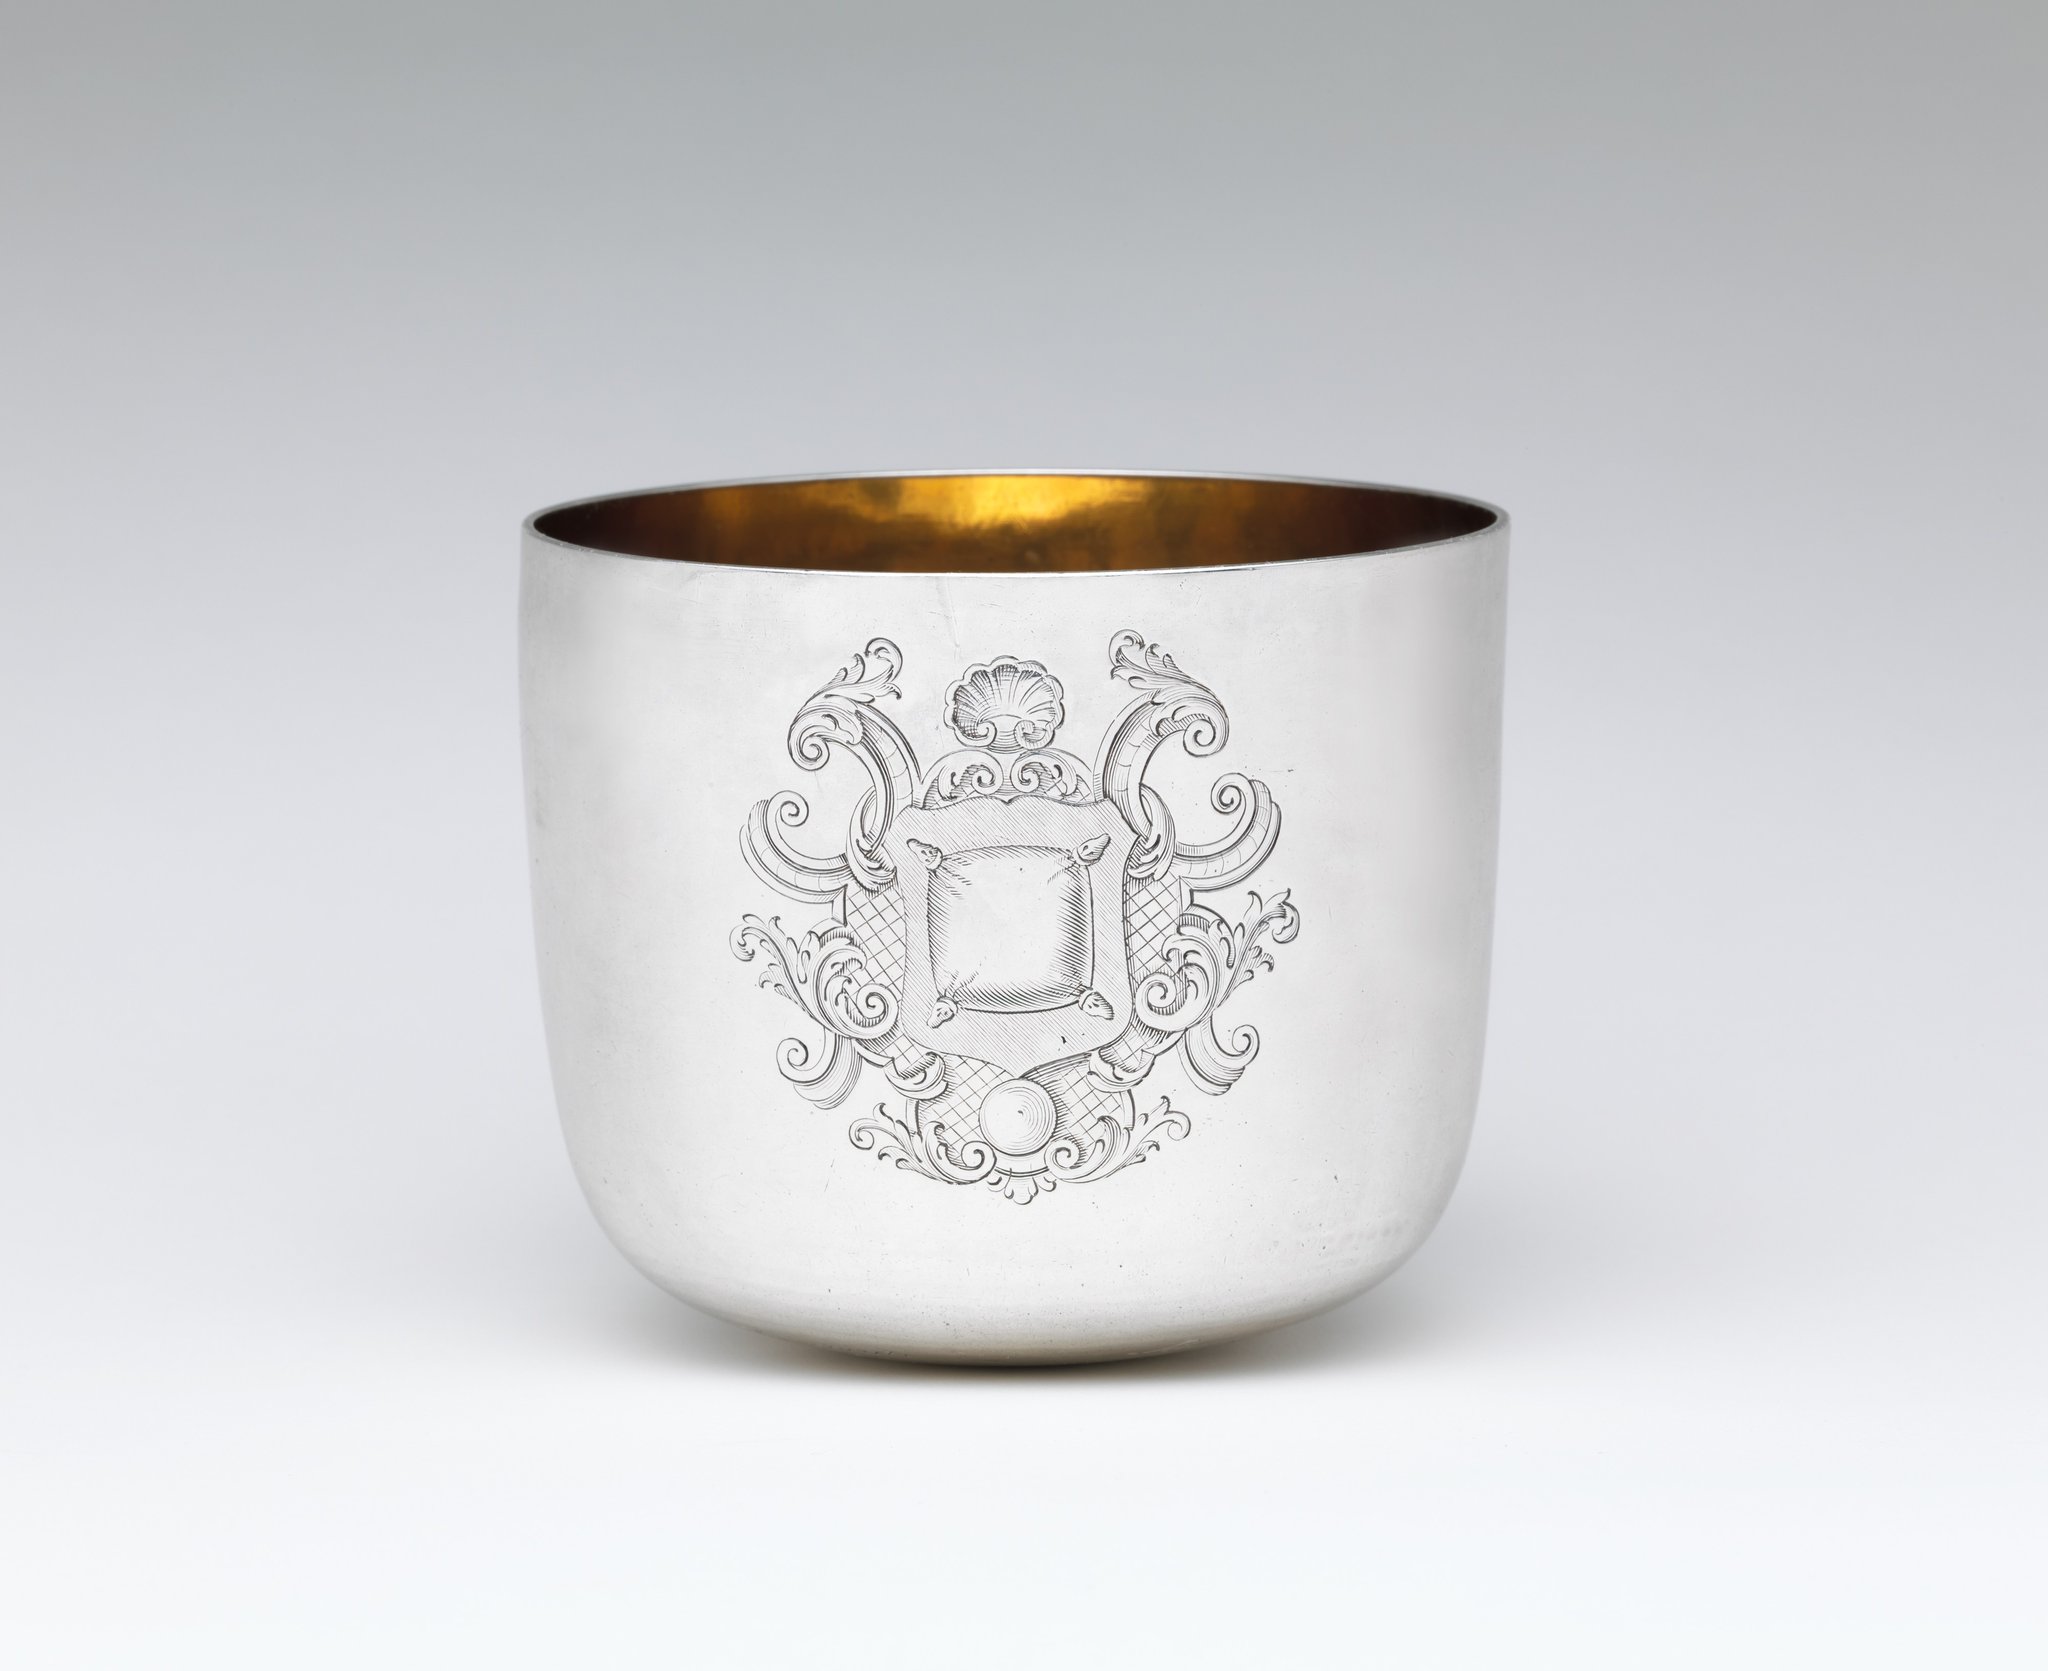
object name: tumbler cup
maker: joseph ward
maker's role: maker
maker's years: 1689-1734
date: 1708-1709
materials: silver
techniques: gilding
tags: coat of arms